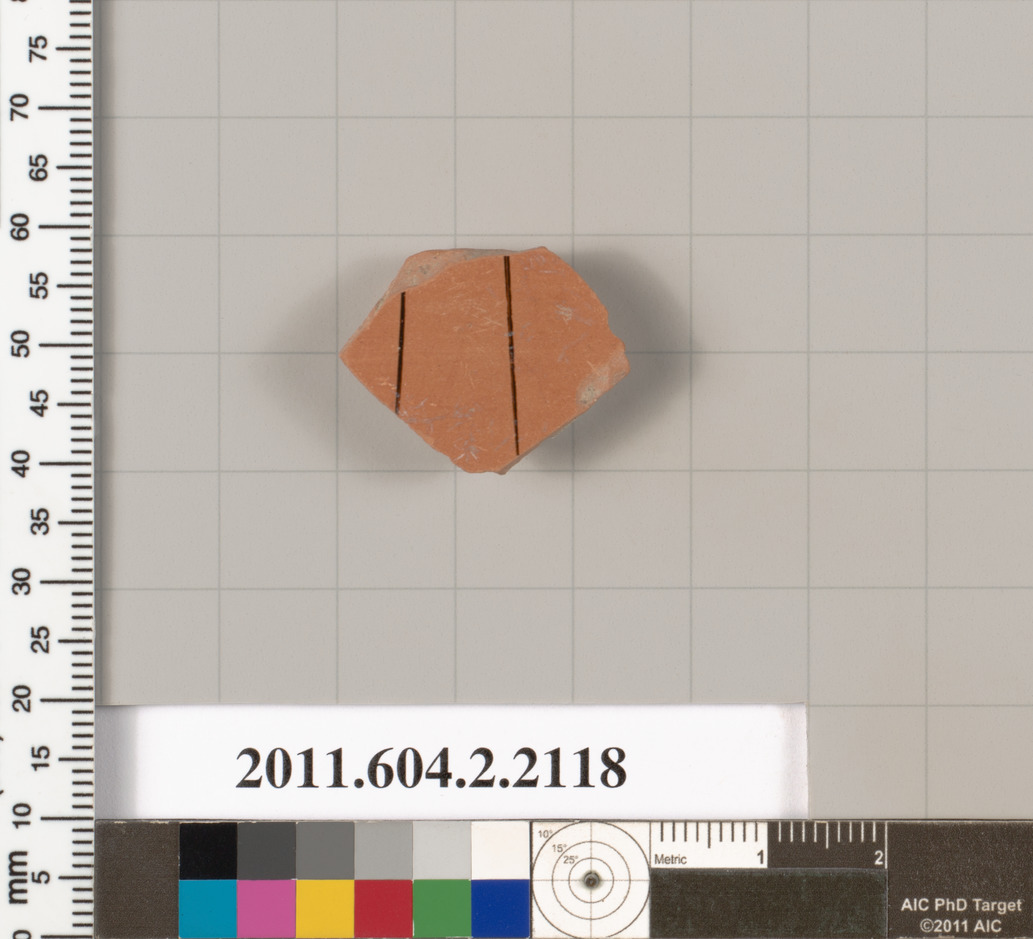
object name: pot fragment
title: Terracotta fragment of a pot; glazed on the inside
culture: greek, attic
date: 475-451 BCE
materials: terracotta